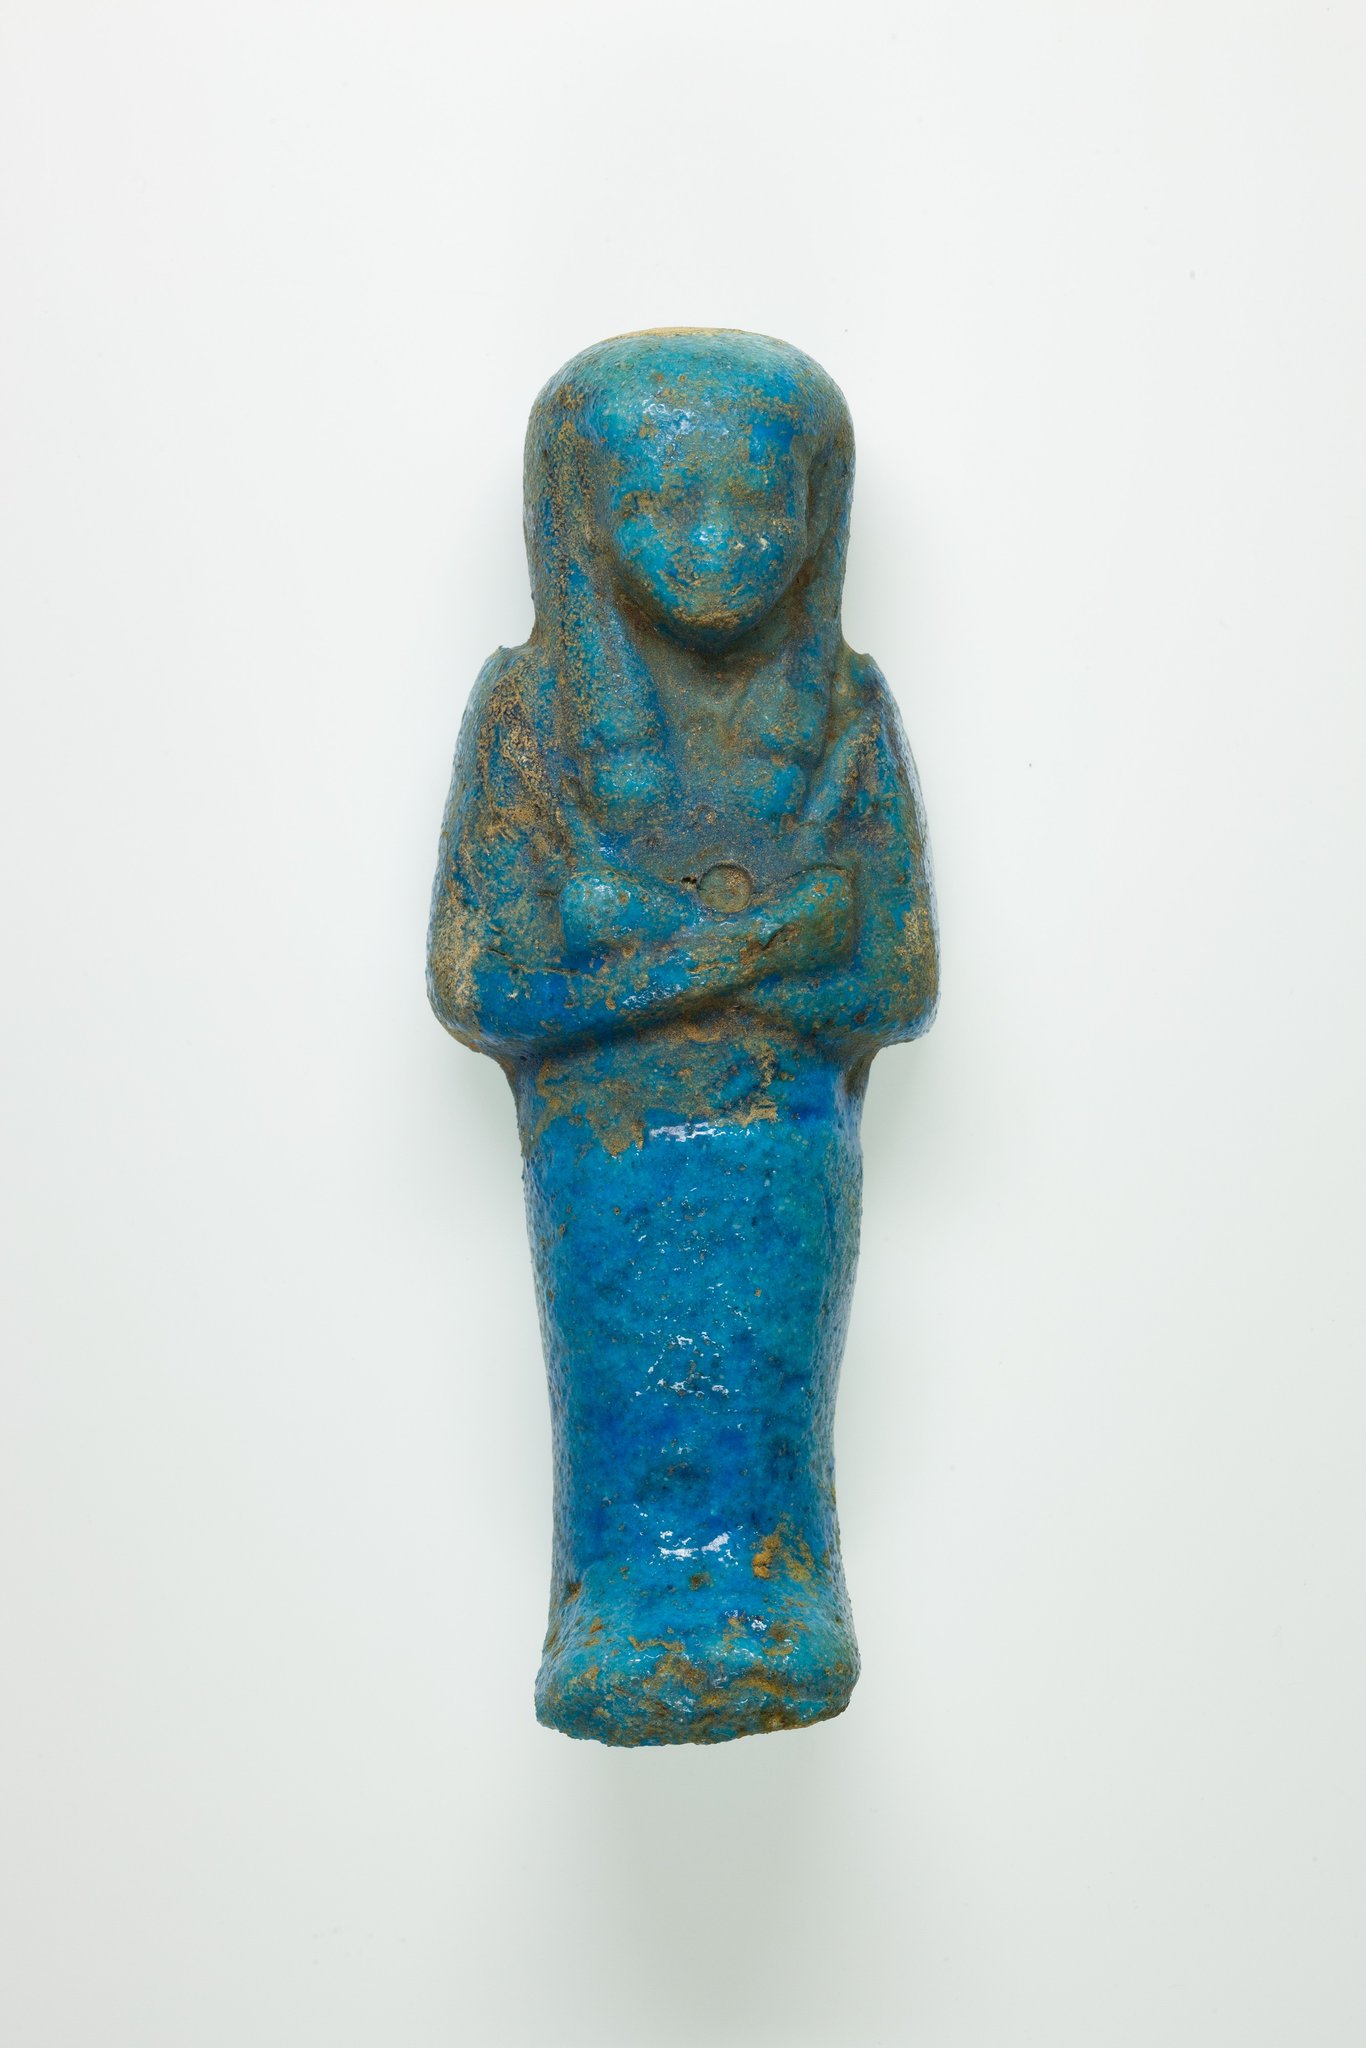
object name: worker shabti, henettawy c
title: Worker Shabti of Henettawy (C), Daughter of Isetemkheb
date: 990-970 BCE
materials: faience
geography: egypt